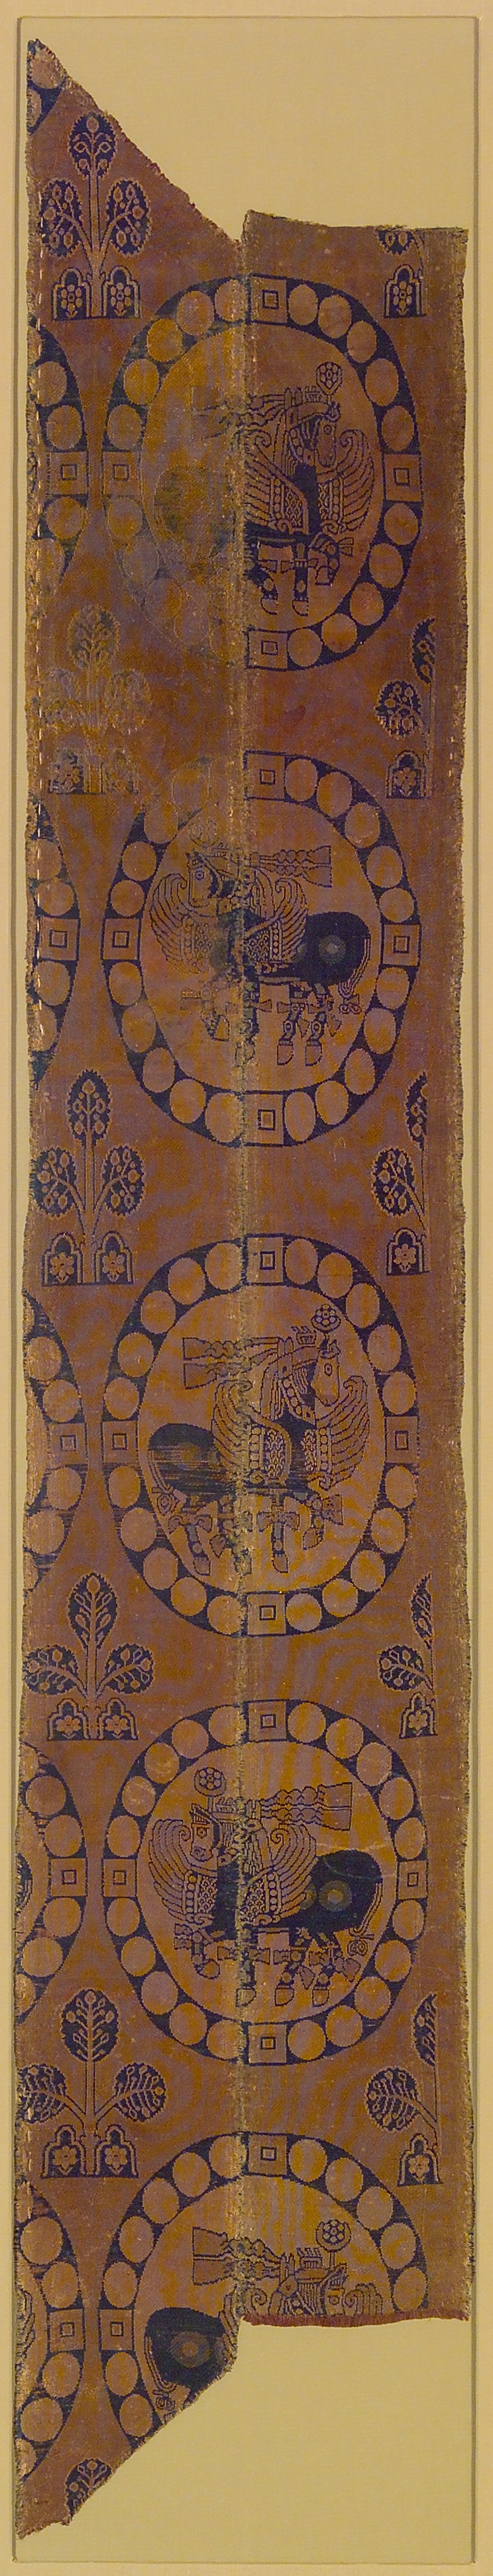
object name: textile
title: Fragment of textile with horses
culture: sasanian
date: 401-700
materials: silk, textile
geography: central asia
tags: horses